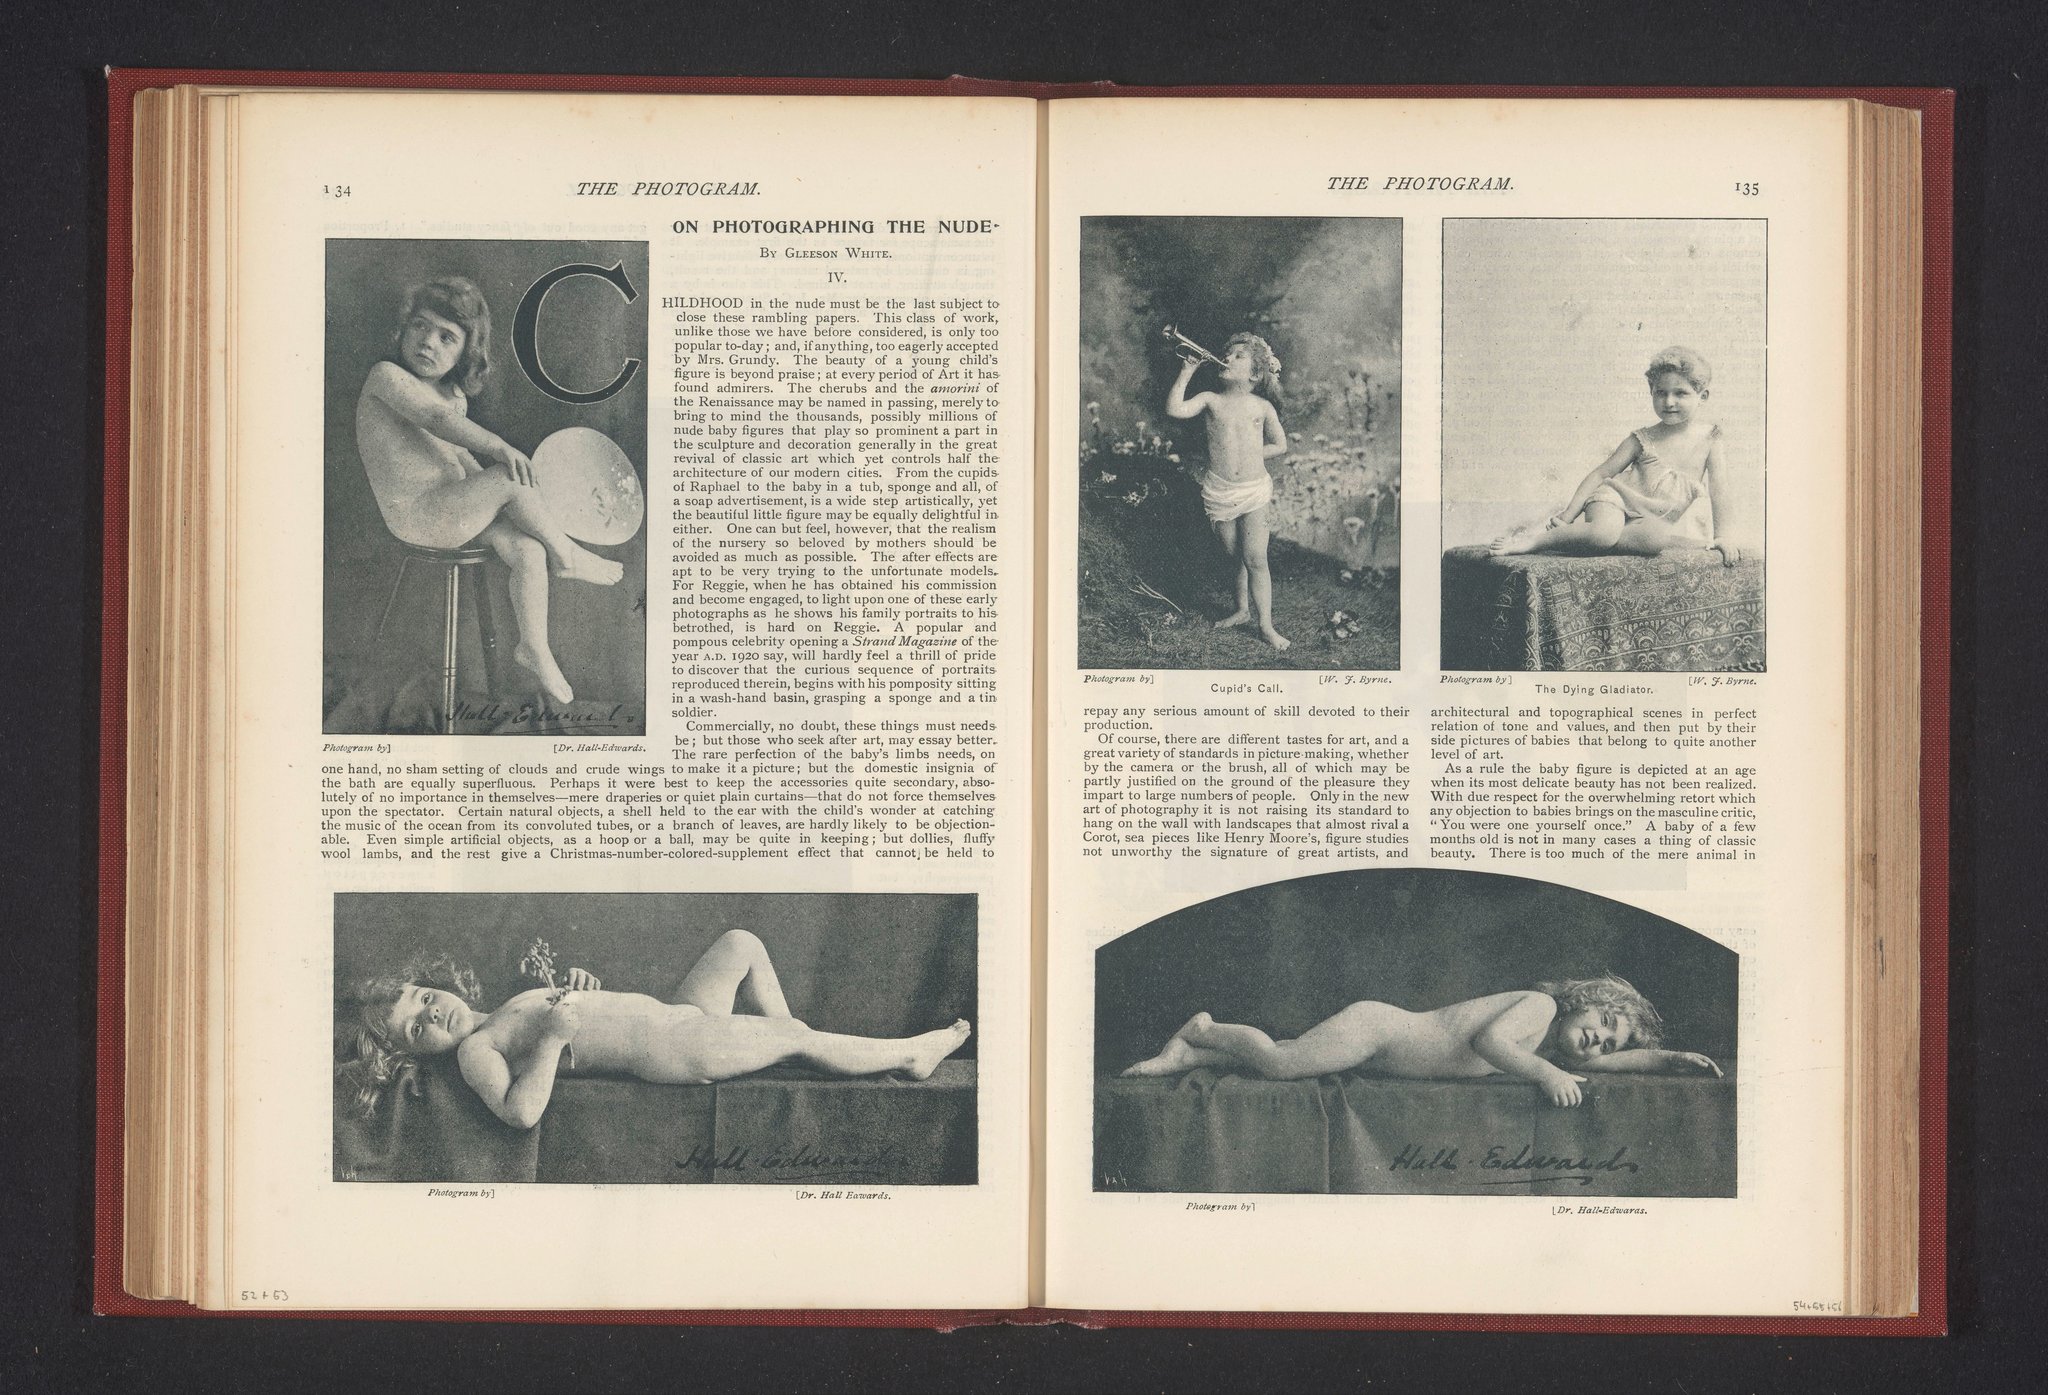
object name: page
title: Portret van een onbekend naakt meisje op een kruk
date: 1889-1894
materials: paper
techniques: autotype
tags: historical persons - bb - woman, girl (child between toddler and youth), the (nude) human figure; 'corpo humano' (ripa) - aa - female human figure